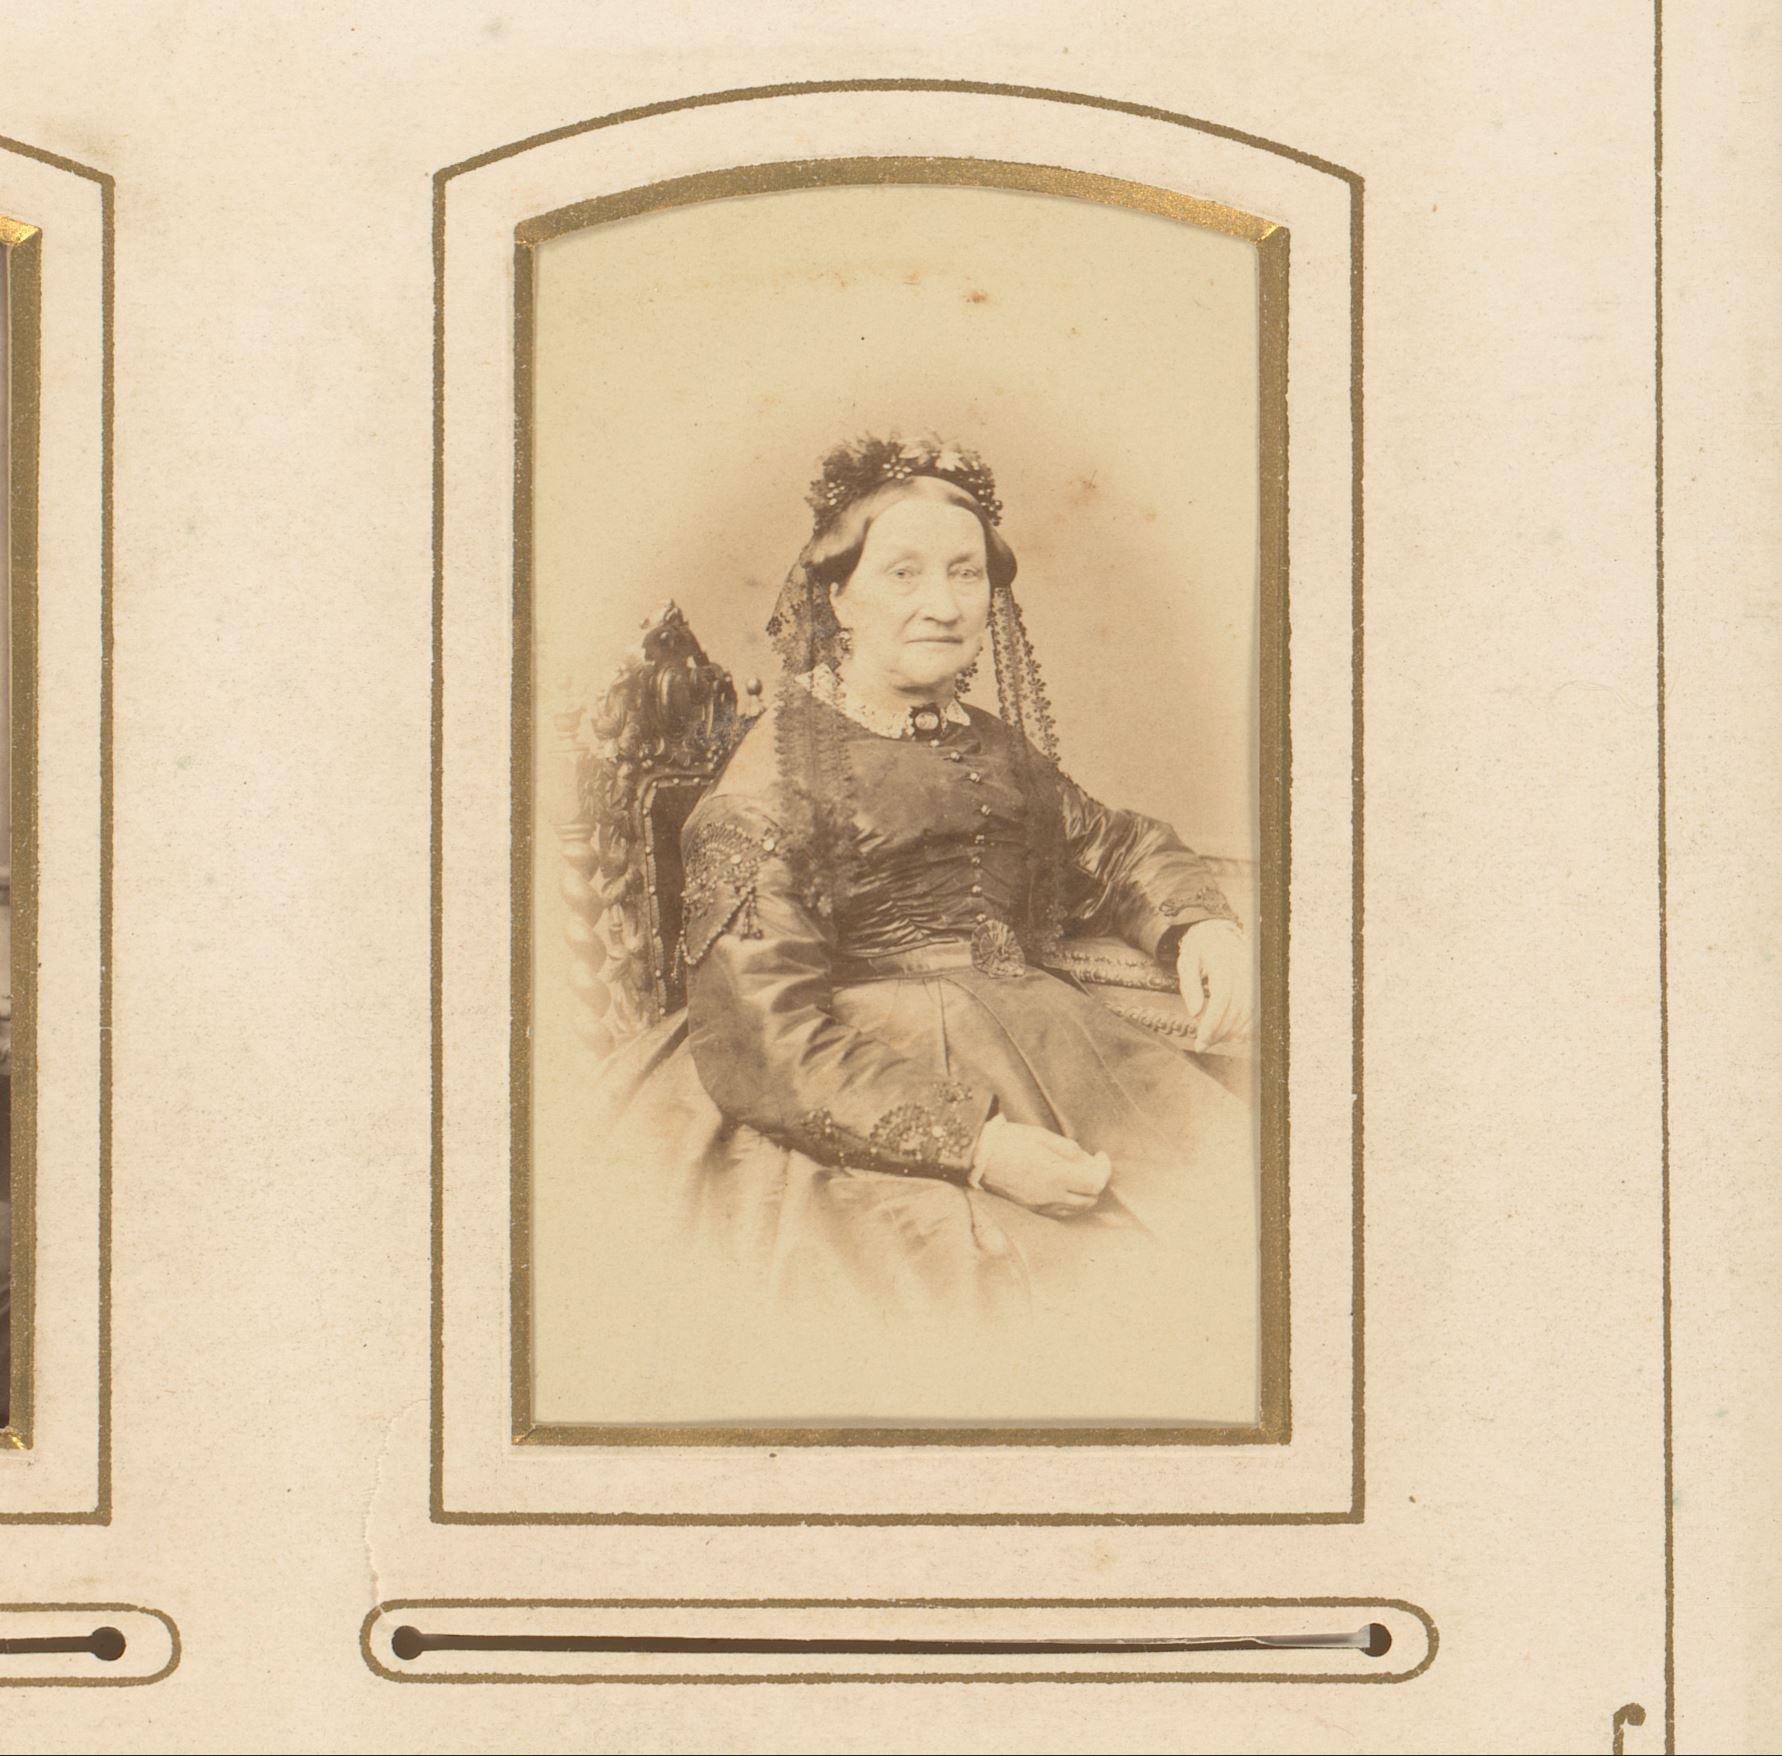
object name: photograph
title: Portret van een vrouw met hoofddeksel, zittend aan een tafel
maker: carel eduard westerborg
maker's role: fotograaf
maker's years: 1842-1916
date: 1861-1900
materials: cardboard, photographic support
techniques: albumen print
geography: arnhem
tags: shelves, rack, sideboard, sitting figure - aa - female human figure, historical persons - bb - woman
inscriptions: inscription: ‘C. E. Westerborg/ Photograaf/ B. 263. Vossenstraat B 263./ ARNHEM.’